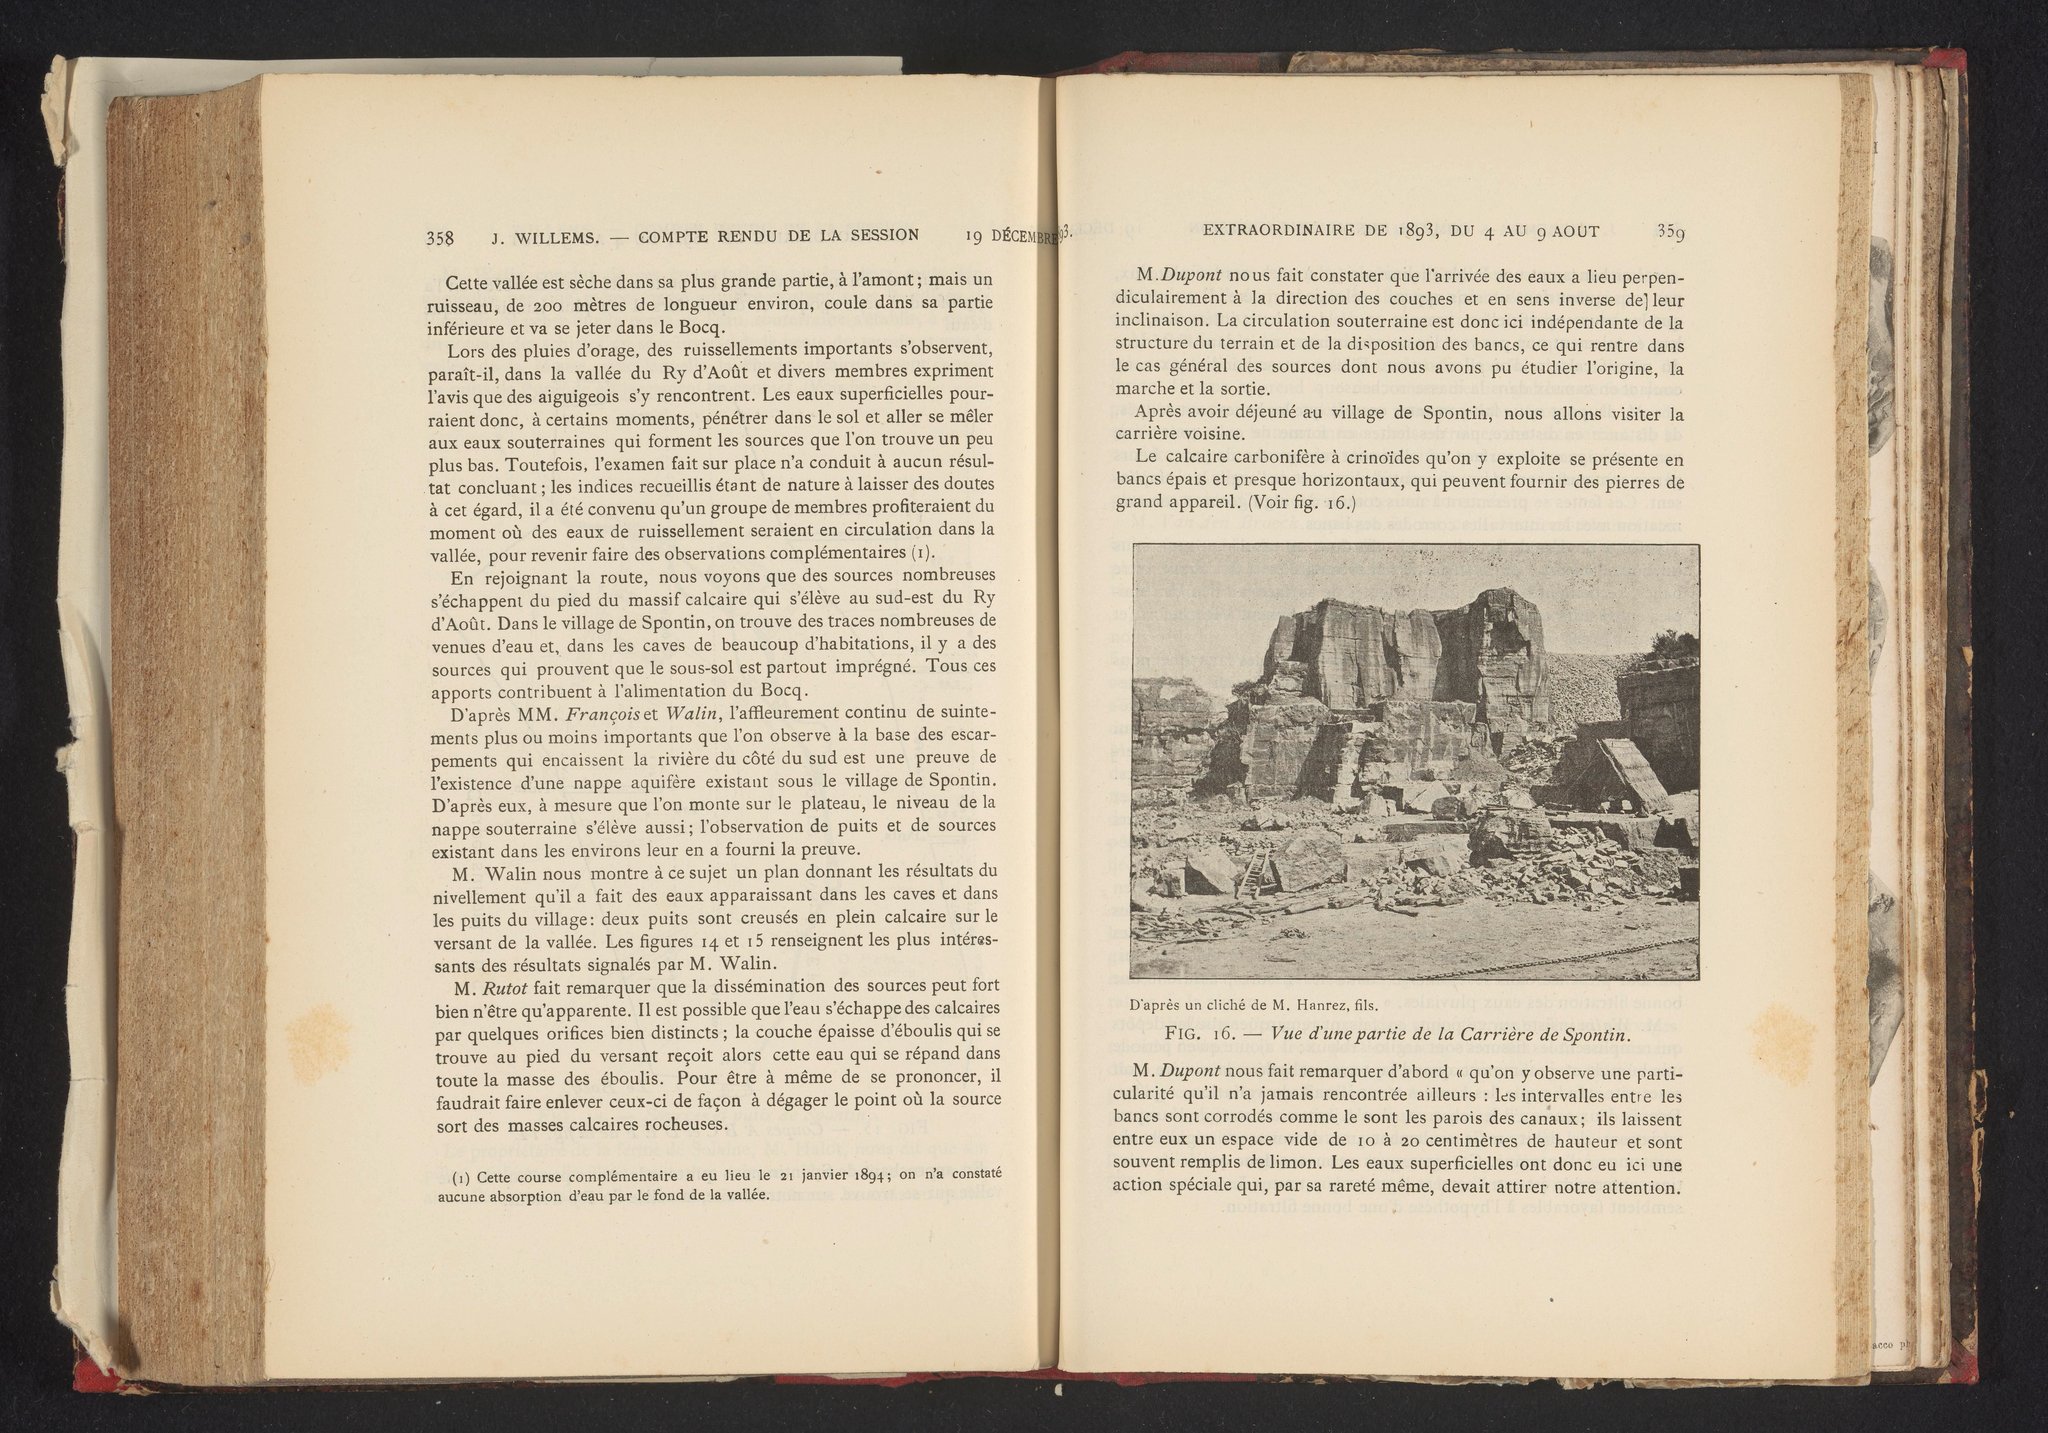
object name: page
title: Vue d'une partie de la Carrière de Spontin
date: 1888-1893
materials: paper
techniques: autotype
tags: quarry